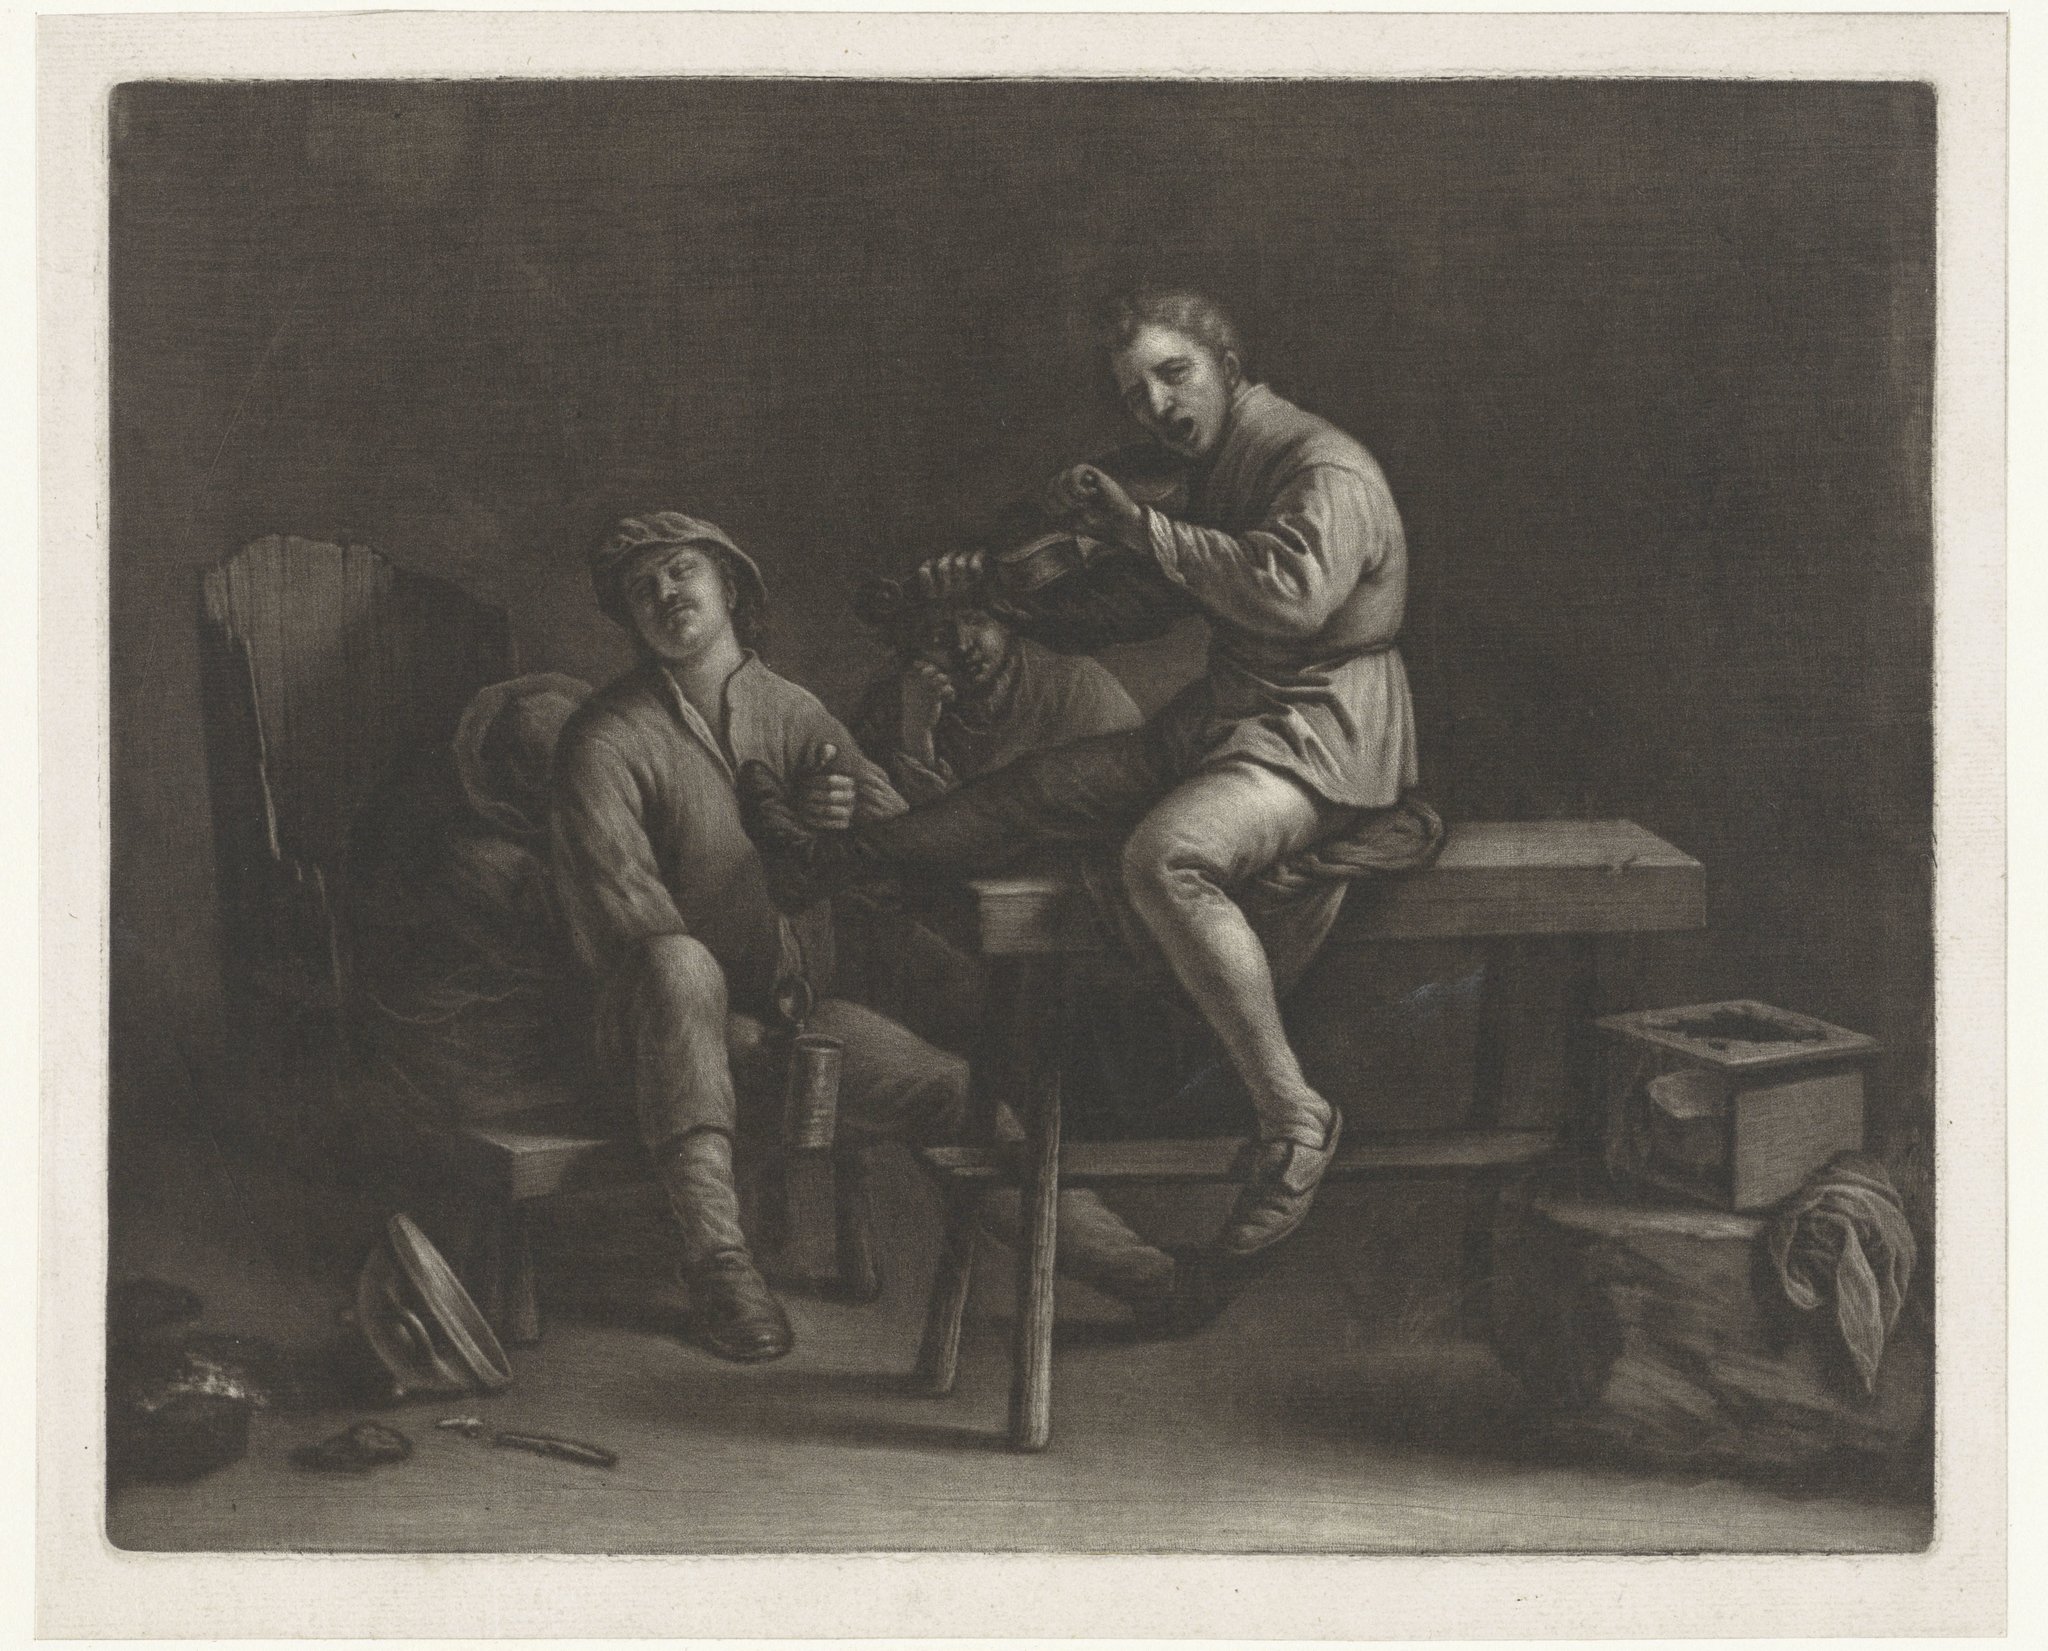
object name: print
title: Vioolspeler in een herberg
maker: wallerant vaillant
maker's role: draughtsman, painter, print maker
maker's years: 1623-1677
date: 1658-1677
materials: paper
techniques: mezzotint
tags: one person playing string instrument (bowed), inn, coffee-house, public house, etc., drinking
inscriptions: collector's mark: Lugt 2228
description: In een heberg zit een man viool te spelen op een tafel. Een tweede man luistert, terwijl twee anderen in slaap zijn gevallen.